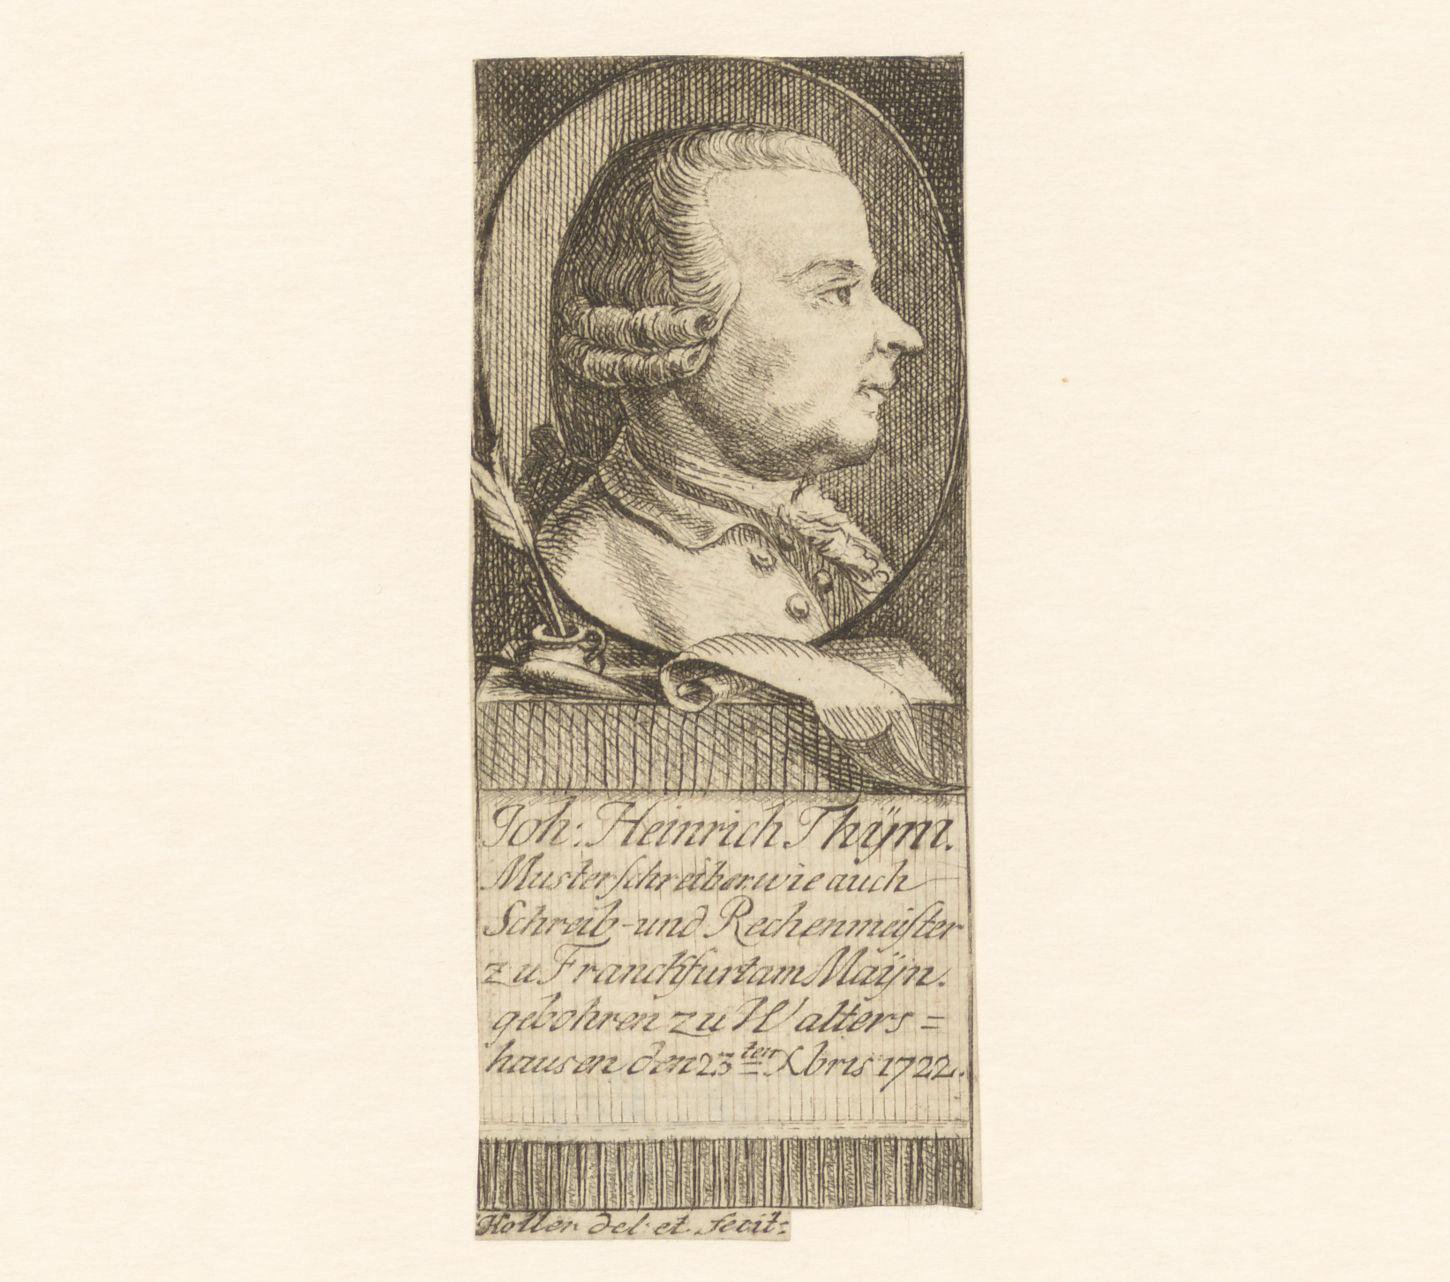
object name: print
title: Portret van Johann Heinrich Thijm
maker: johann jakob koller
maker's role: print maker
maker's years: 1746-1805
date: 1756-1805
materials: paper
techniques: etching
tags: historical persons, notary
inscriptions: collector's mark: Lugt 2228